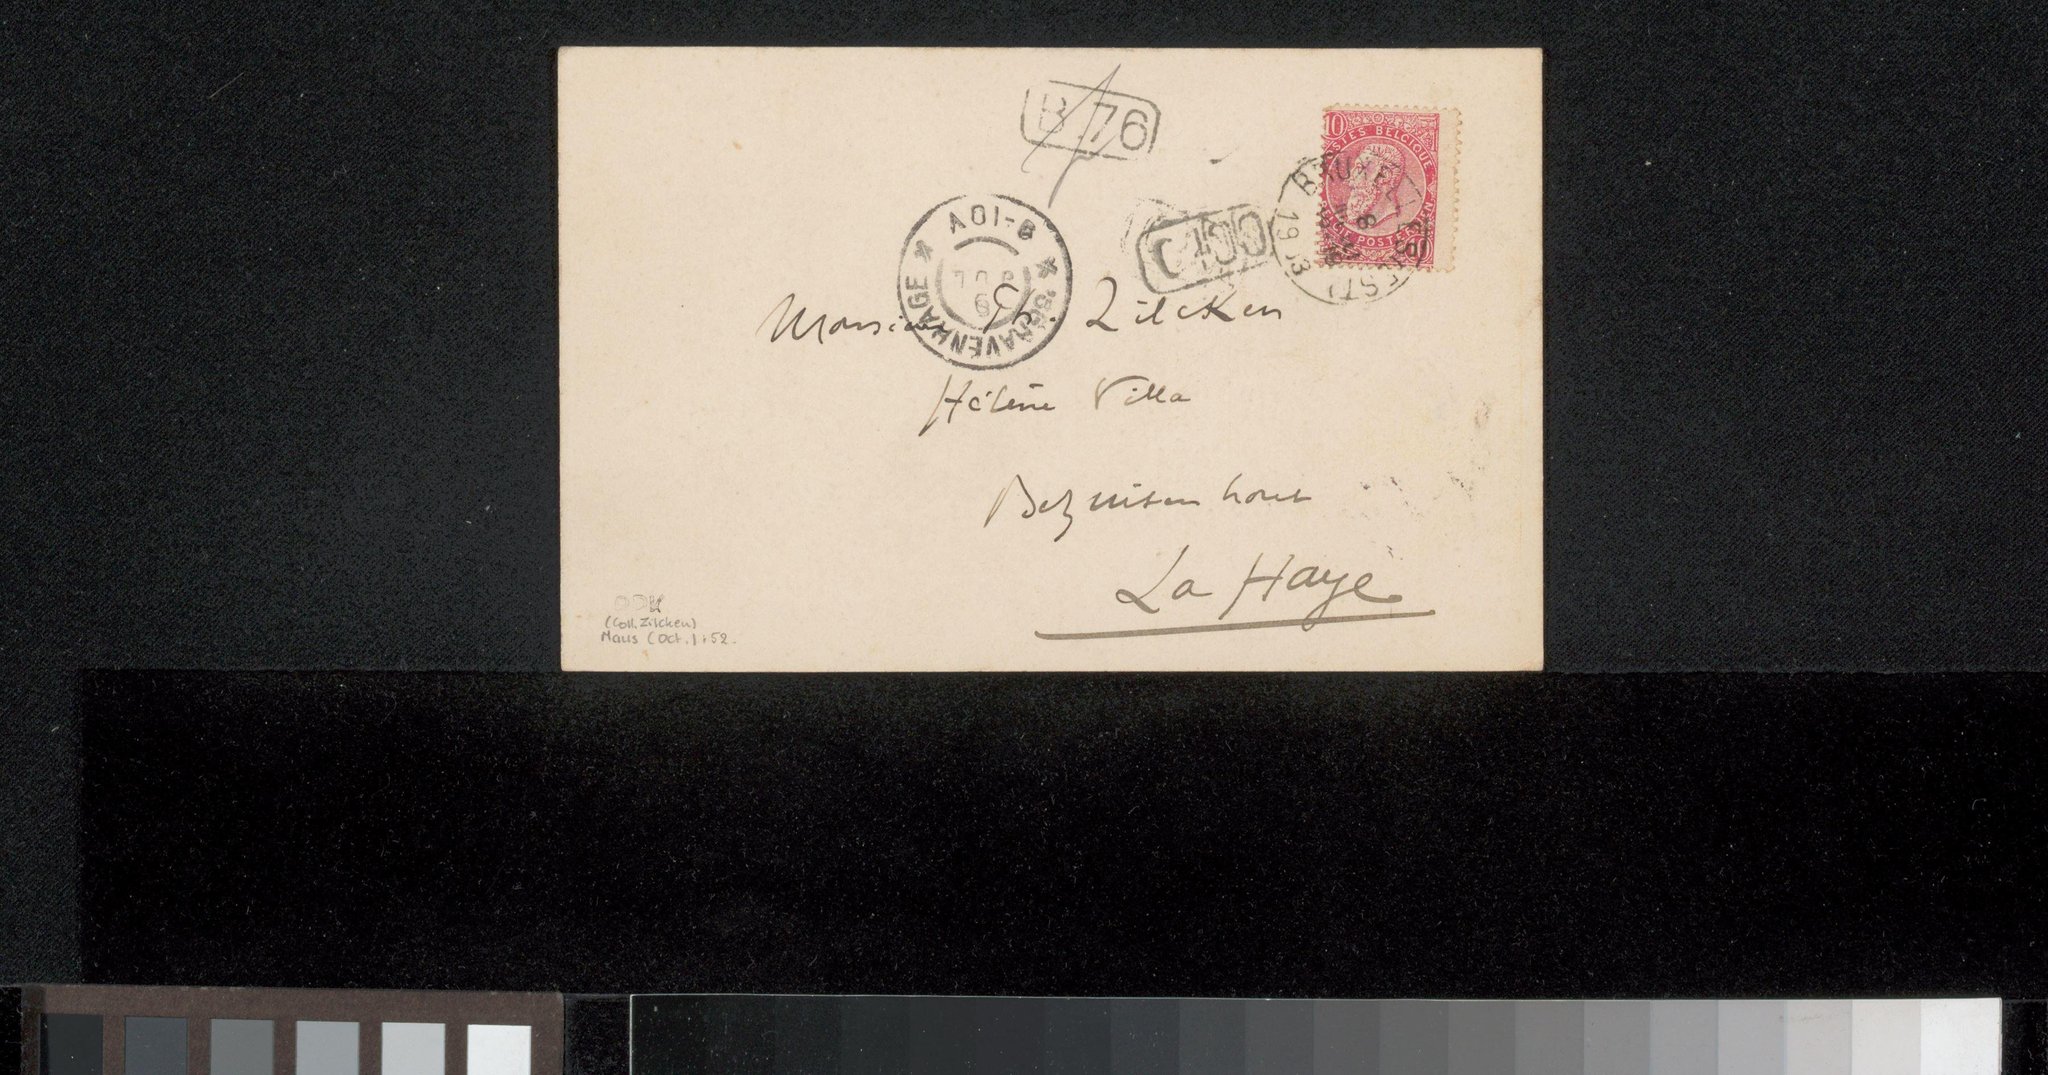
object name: letter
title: Brief aan Philip Zilcken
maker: octave maus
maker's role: painter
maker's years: 1856-1919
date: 1903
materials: cardboard, ink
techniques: pen, printing, writing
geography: brussels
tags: the hague, painter, draughtsman, philip zilcken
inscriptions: collector's mark: ‘RPK’